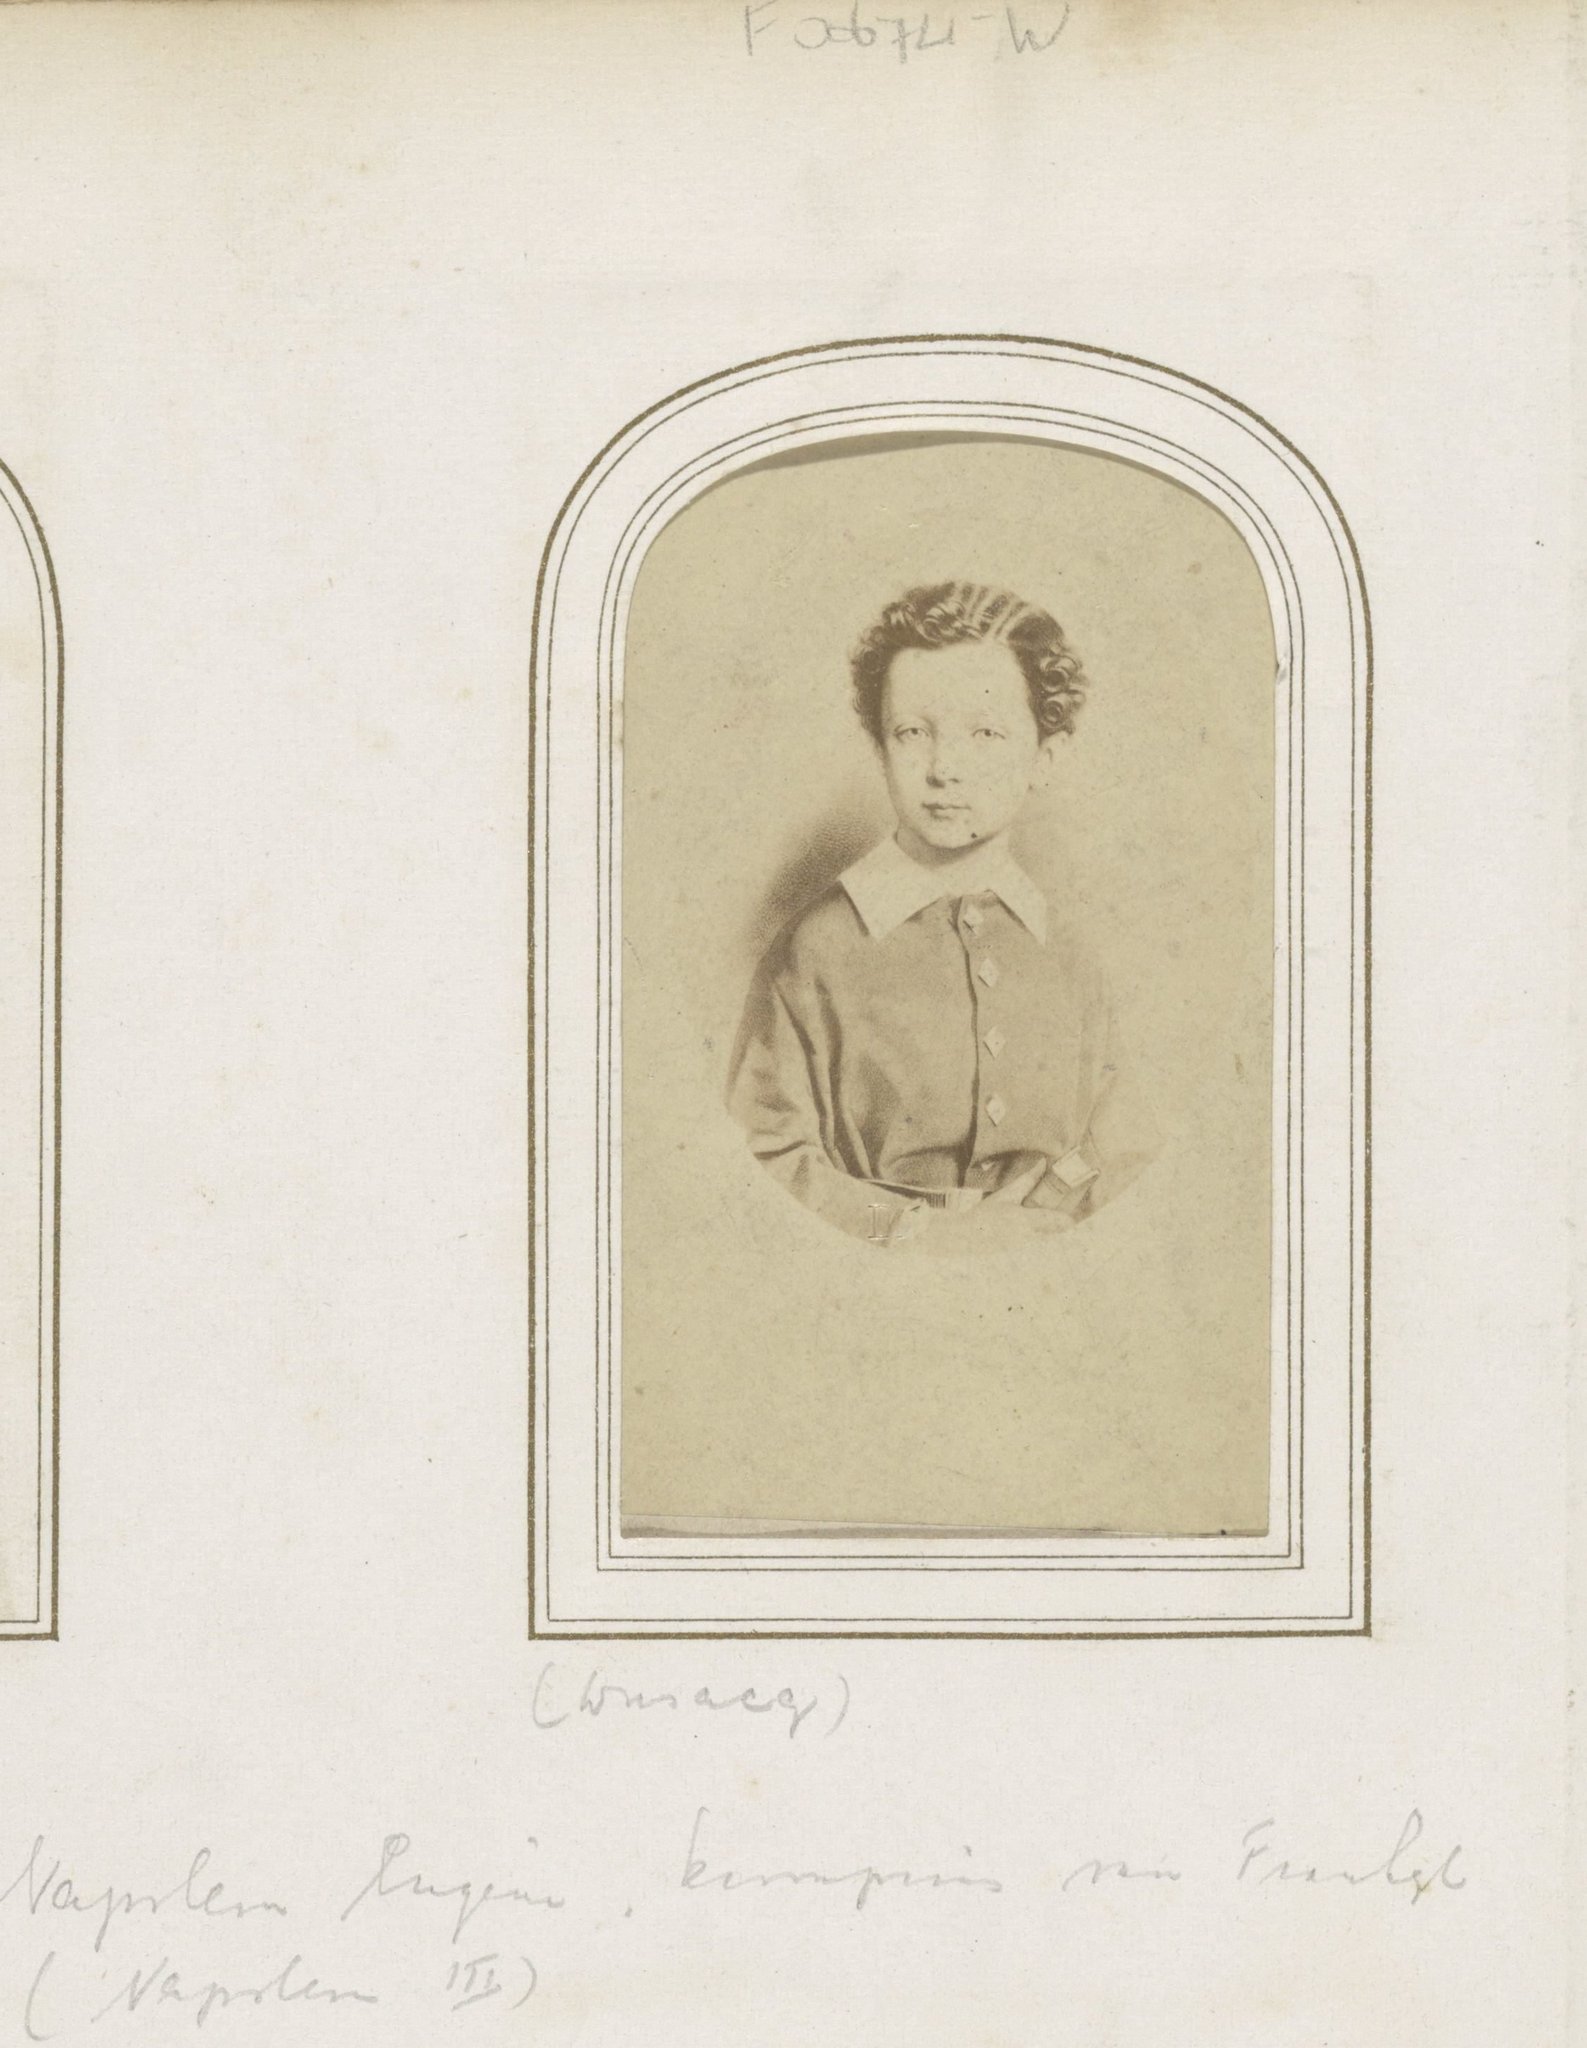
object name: carte de visite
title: Fotoreproductie van (vermoedelijk) een getekend portret van Napoleon Eugène, kroonprins van Frankrijk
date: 1858-1870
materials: cardboard, paper, photographic support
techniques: albumen print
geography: paris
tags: child, historical persons, clothing for the upper part of the body, hairdress, paris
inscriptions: check stamp: ‘P.V.’, address: ‘14. Boulevart Poissonnière. 14 Paris’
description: Onderdeel van Fotoalbum met 123 cartes-de-visite van leden van Europese vorstenhuizen, politici en bekende personen.